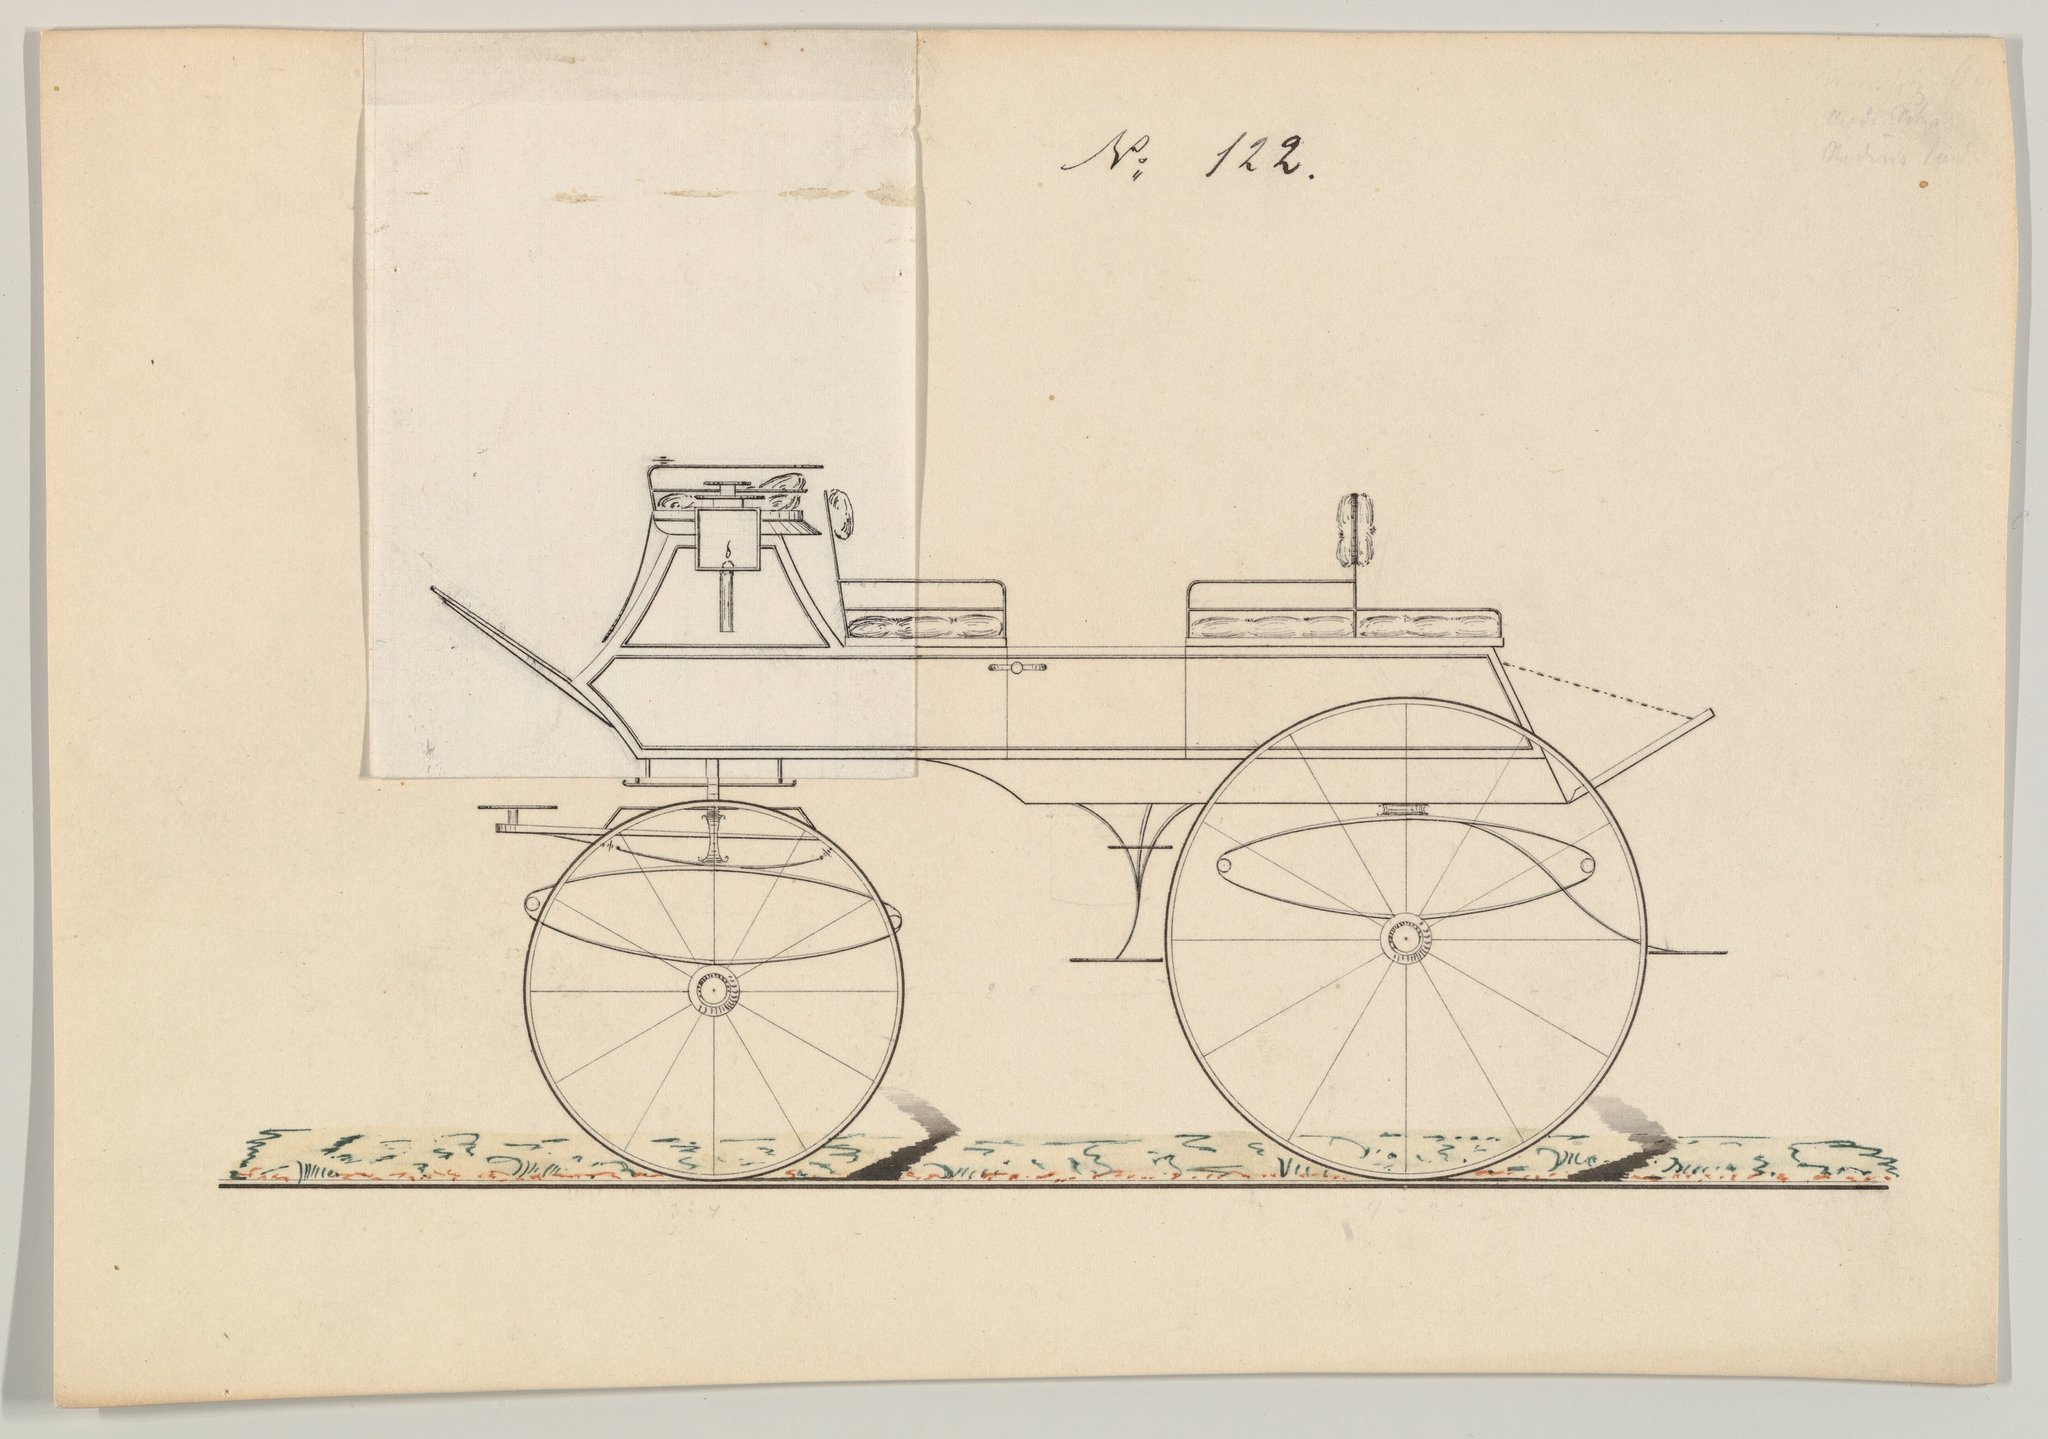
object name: drawing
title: Drag #122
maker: brewster & co.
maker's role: manufacturer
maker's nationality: american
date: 1865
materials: ink, watercolor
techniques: pen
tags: carriages